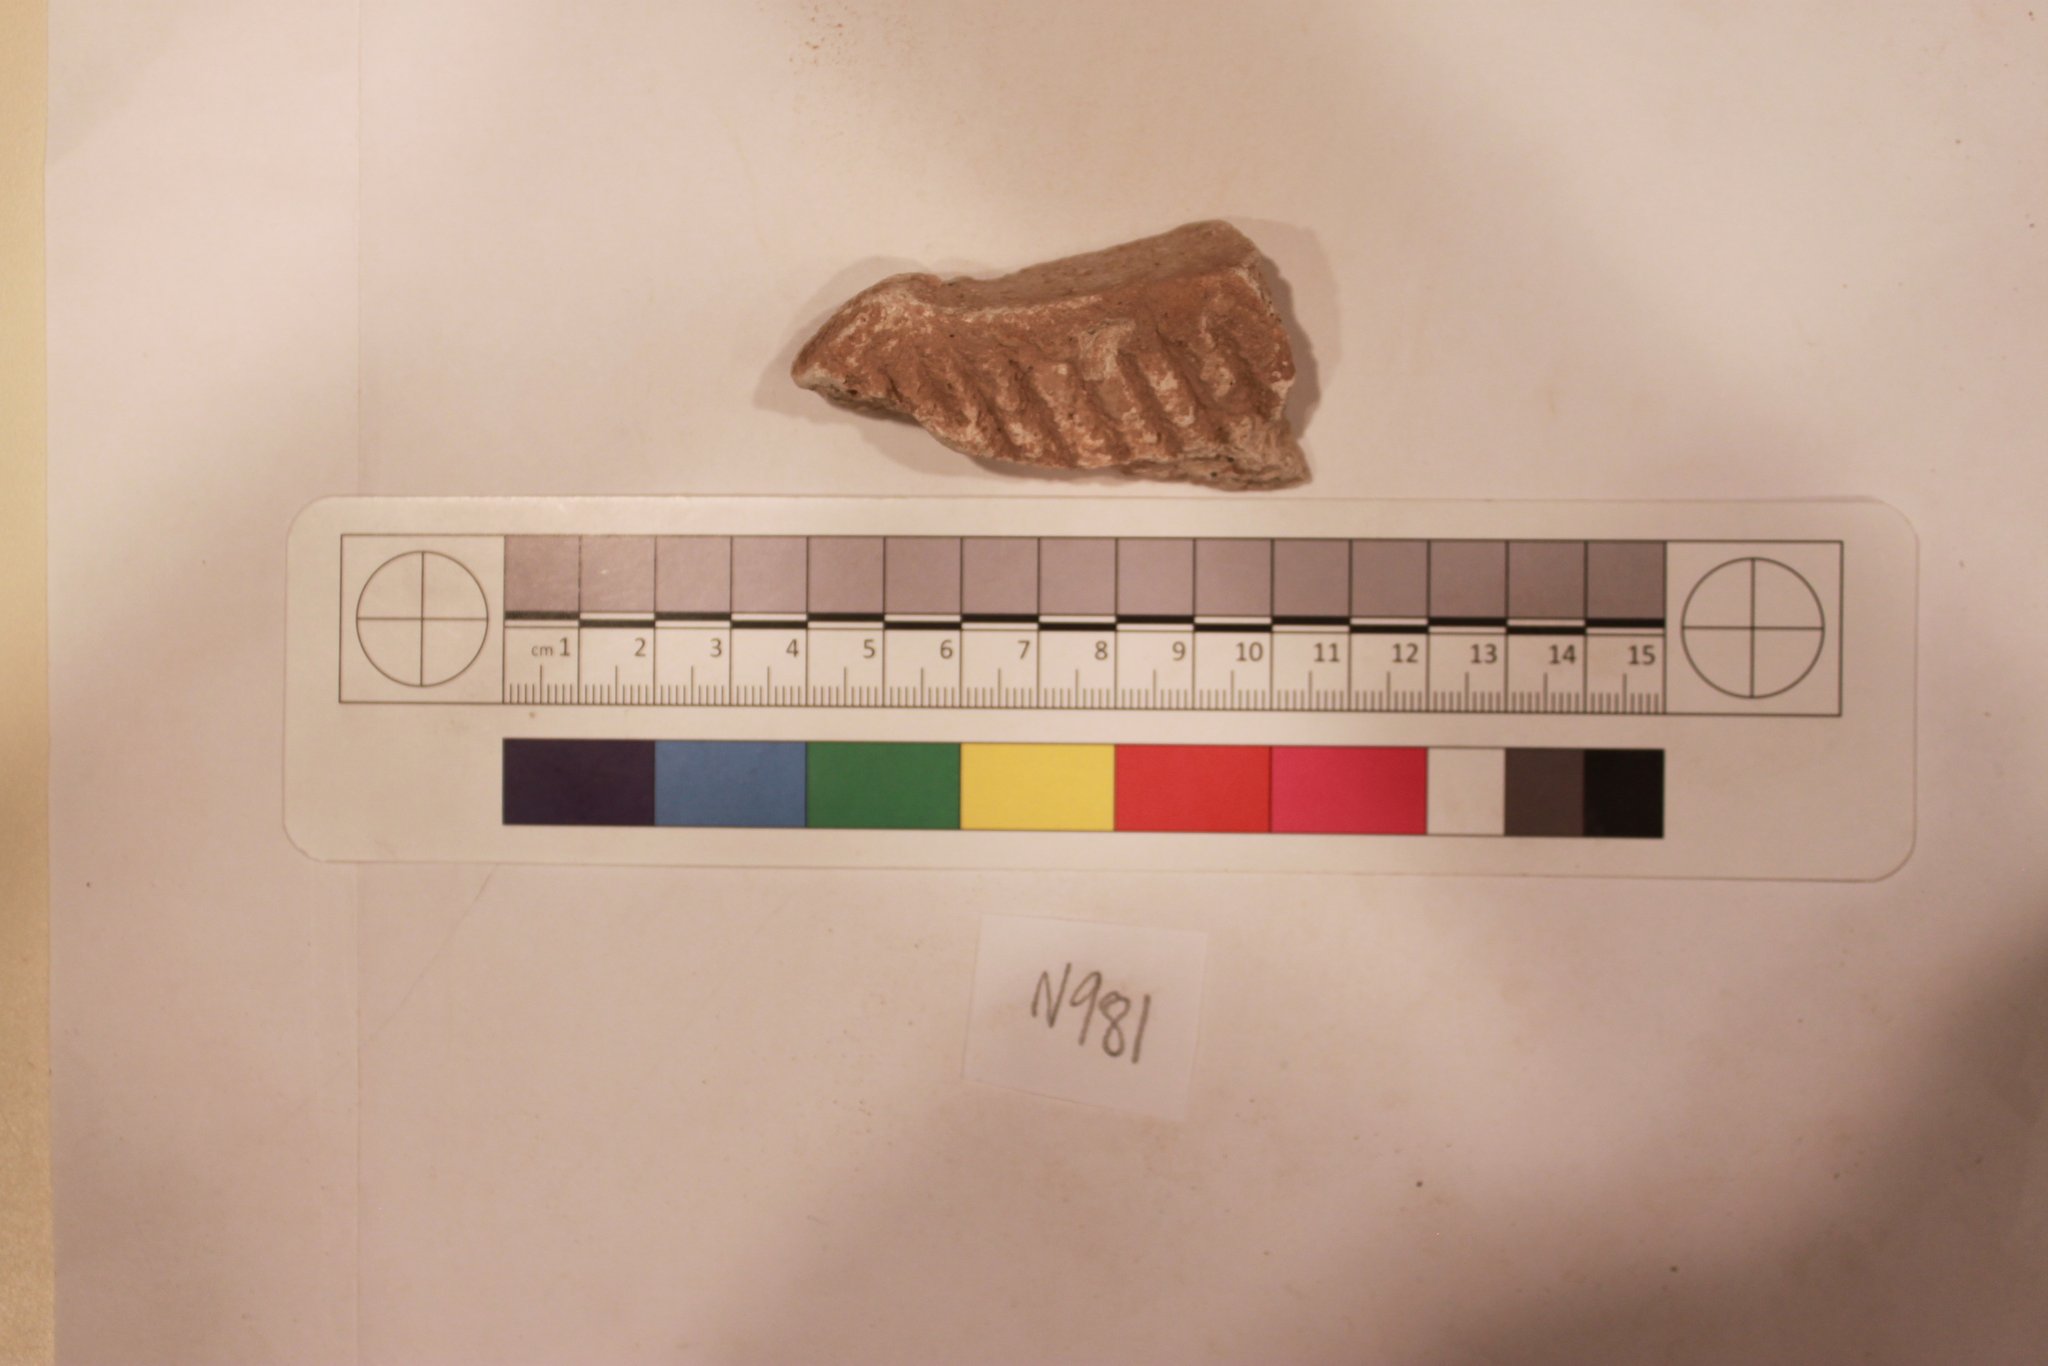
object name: fragment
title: Stucco Fragment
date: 701-1200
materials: plaster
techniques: carving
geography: iran